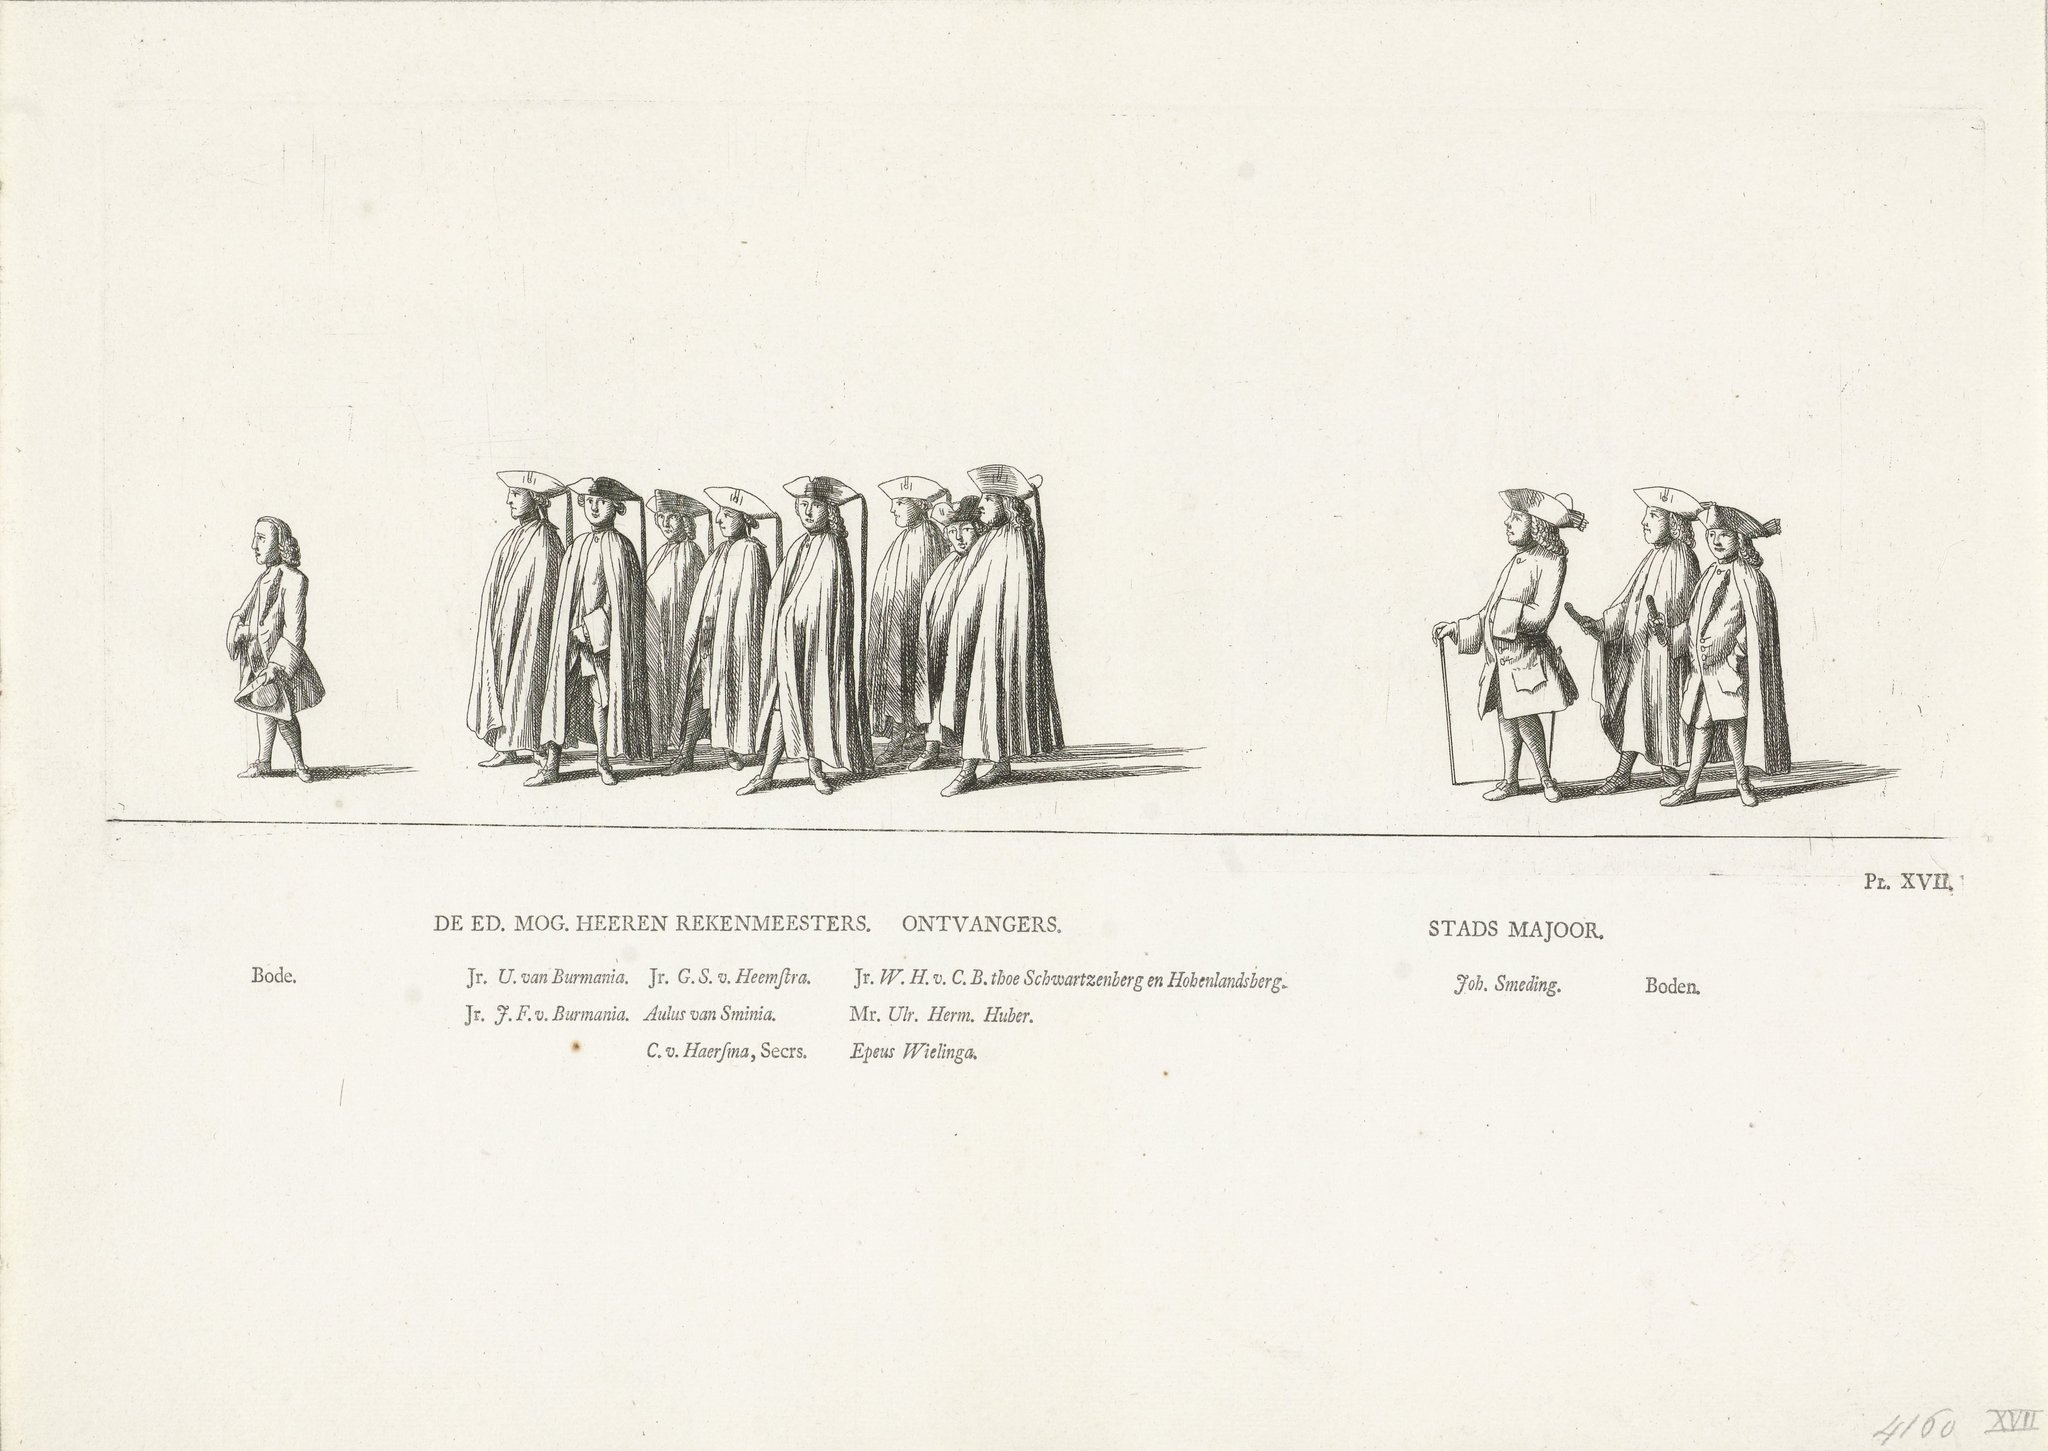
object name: print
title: Lijkstatie van prinses Maria Louise, 1765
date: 1765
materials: paper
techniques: etching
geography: leeuwarden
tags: cortege, funeral procession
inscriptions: date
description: Notabelen. Gemerkt rechtsonder: Pl. XVII. Op het blad onder de plaat de namen van personen in de stoet. Onderdeel van de serie platen van de begrafenis van prinses Maria Louise te Leeuwarden op 13 juni 1765.